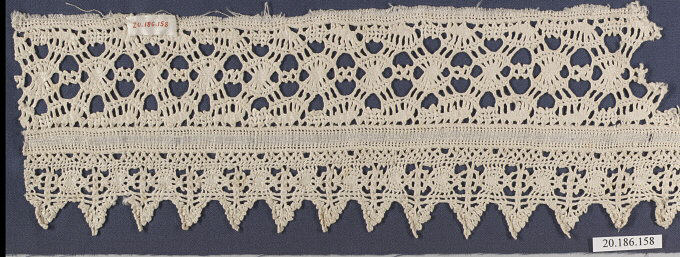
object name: edging and insertion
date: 1501-1700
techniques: lace